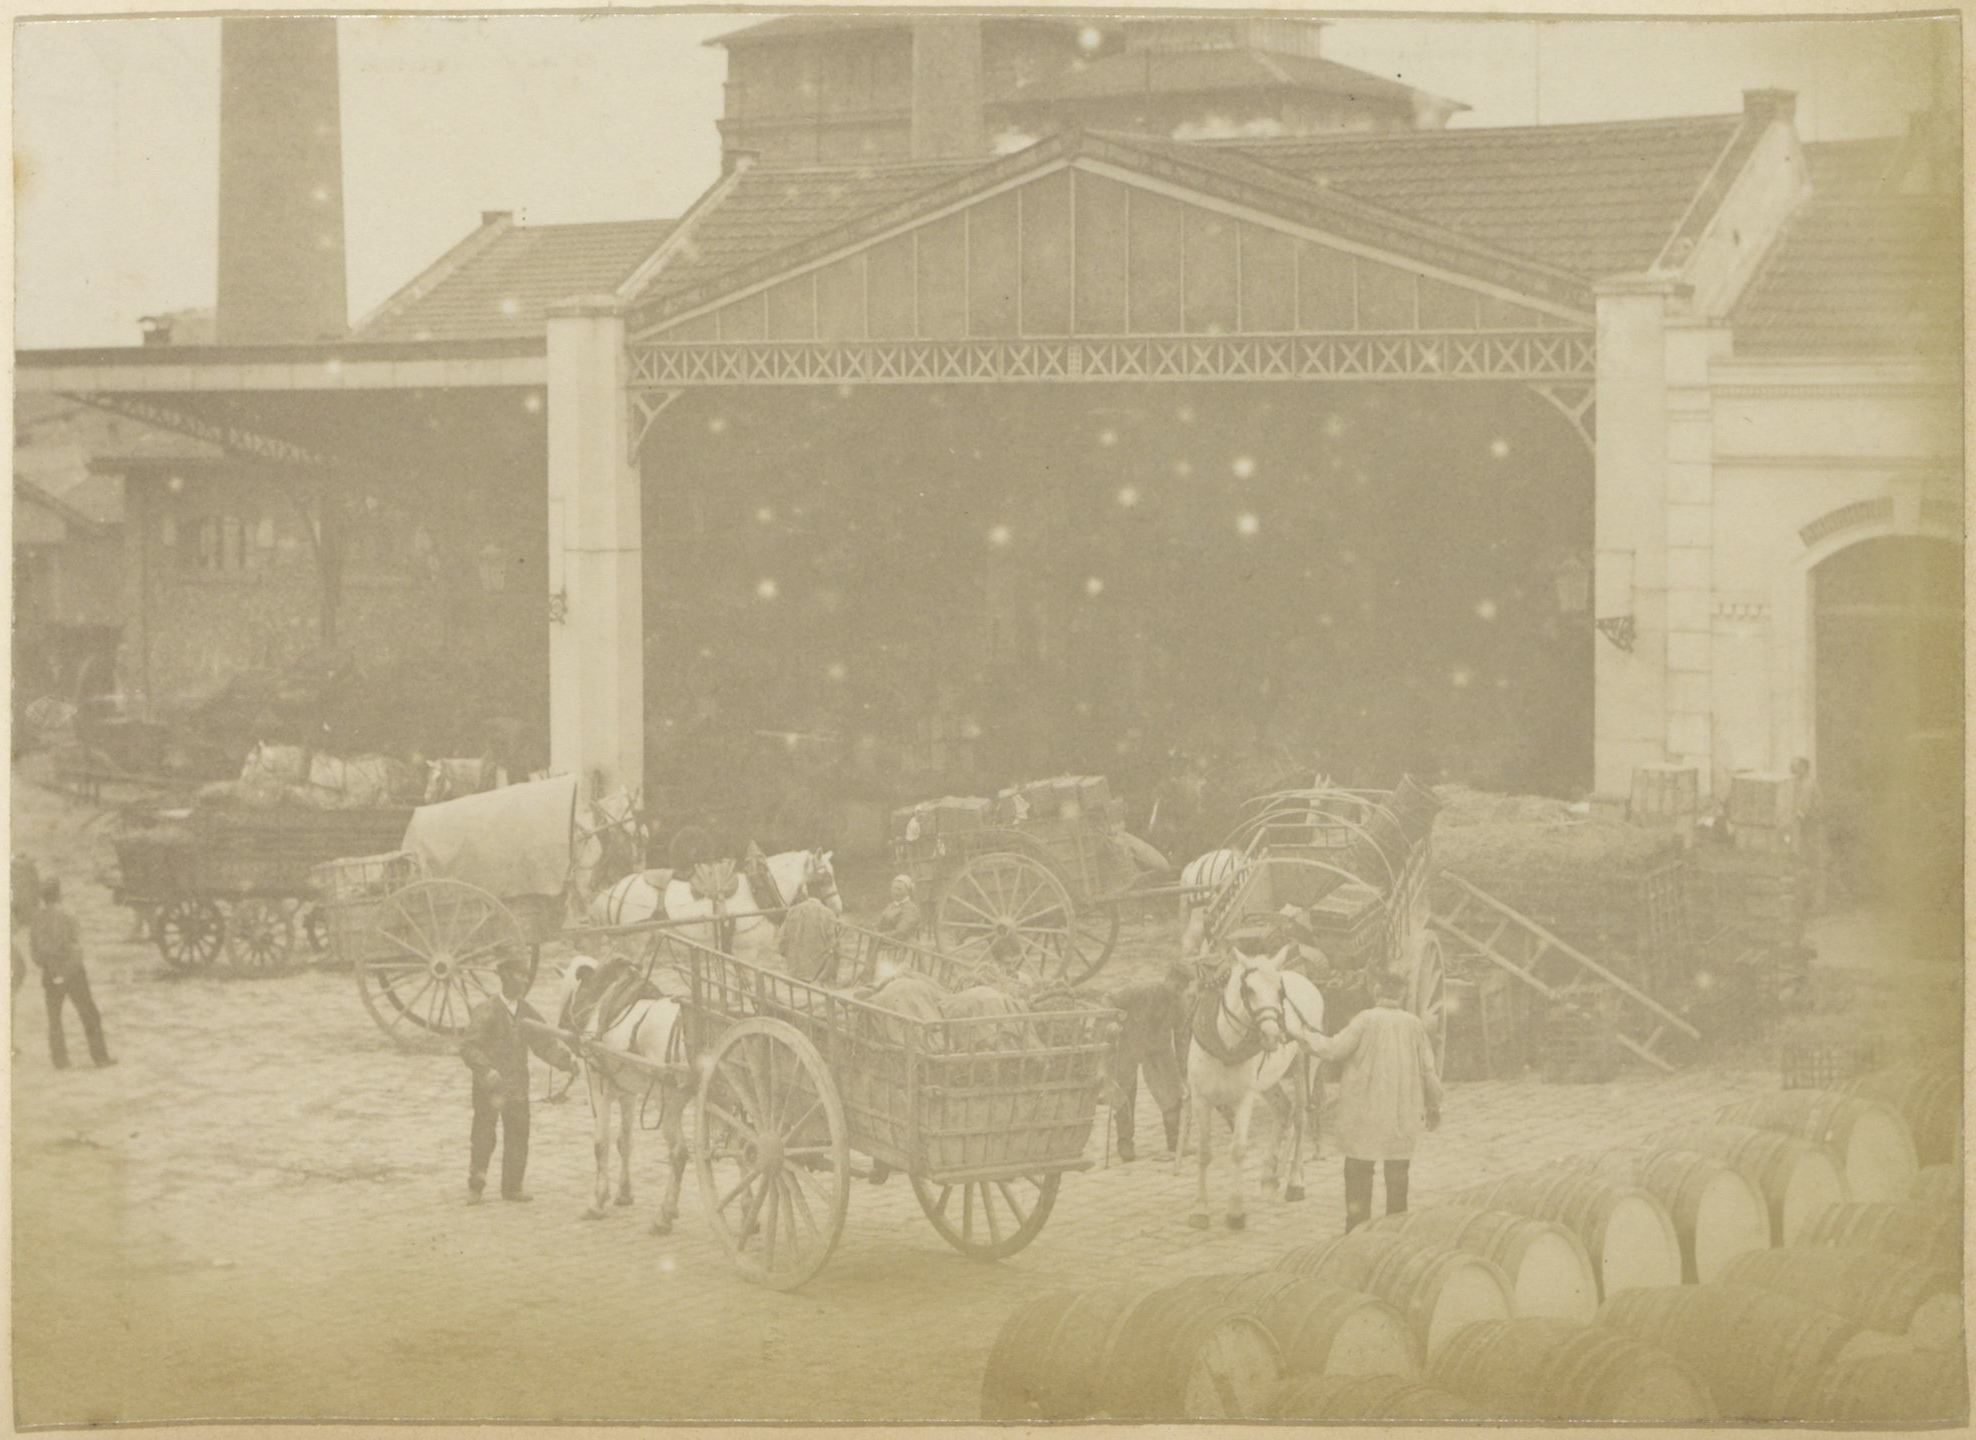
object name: photograph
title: Bedrijfsterrein van distilleerderij Delizy & Doistau Fils in Pantin met paardenkarren, loods en vaten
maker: Anonymous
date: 1900-1910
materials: paper, photographic support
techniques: albumen print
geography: pantin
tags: factory-building, four-wheeled, animal-drawn vehicle, e.g.: cab, carriage, coach, courtyard, alcoholic drinks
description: Onderdeel van Fotoalbum van een Franse amateurfotograaf met opnames van een familie, distilleerderij Delizy & Doistau Fils, het leger en bezienswaardigheden in Frankrijk.